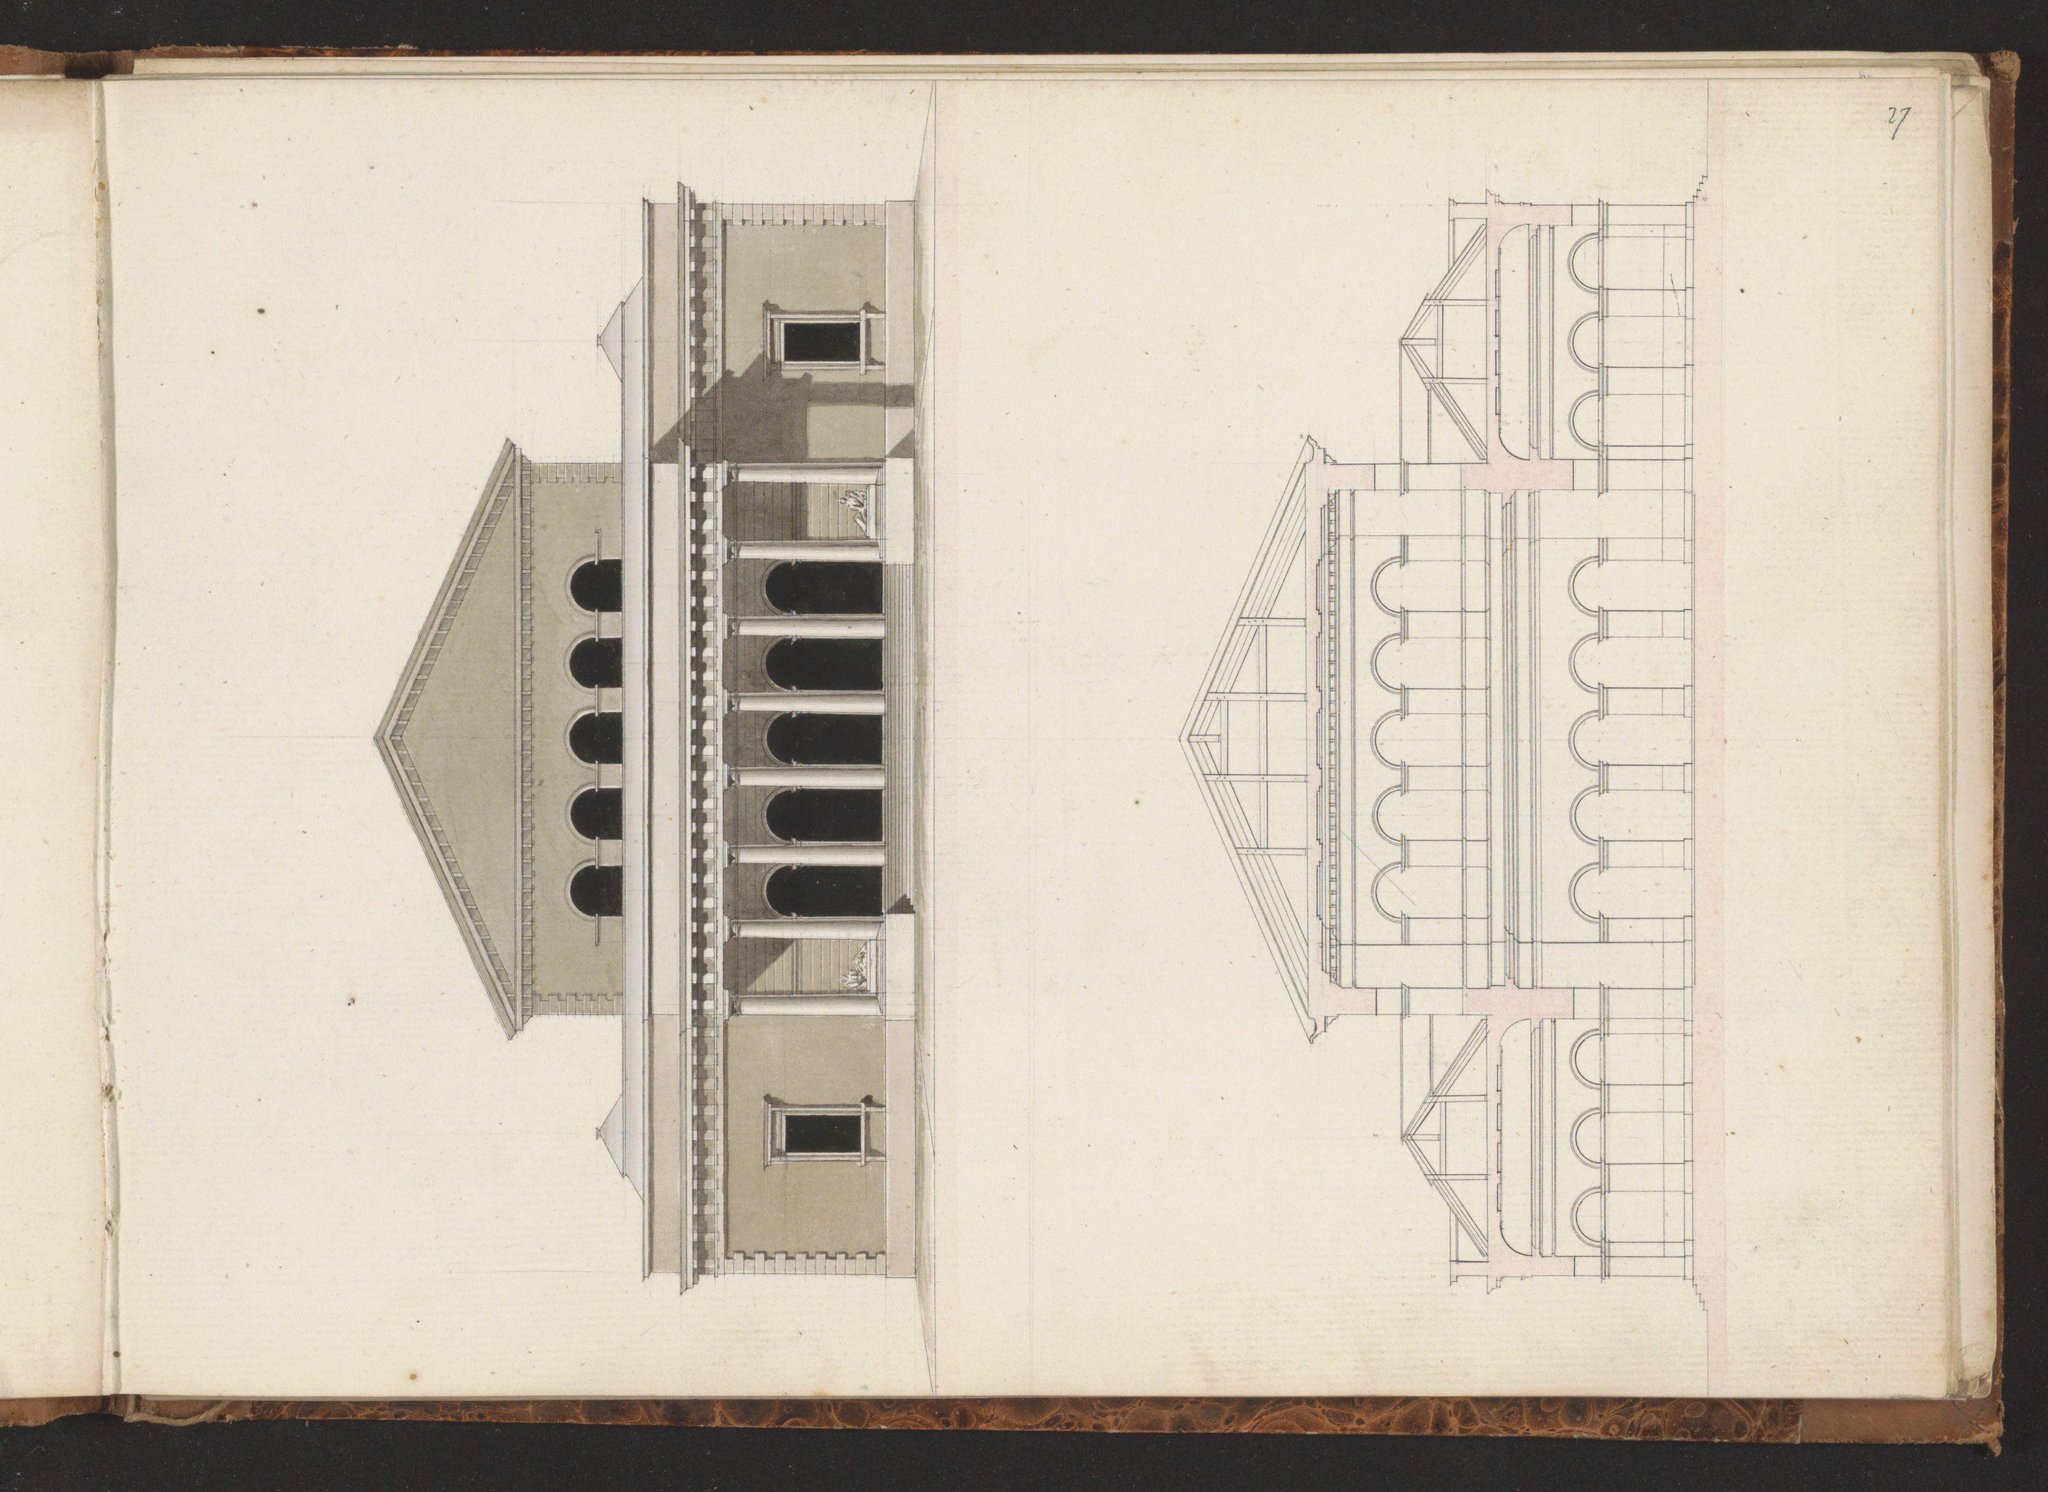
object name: sketchbook leaf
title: Opstand van de voorgevel en doorsnede van een villa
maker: willem springer jr.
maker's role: draughtsman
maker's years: 1815-1907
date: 1825-1907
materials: ink, paper, pencil, watercolor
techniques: brush, pen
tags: façade (of house or building), section ~ architectural design or model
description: Pagina 27 uit een schetsboek met 86 pagina's.